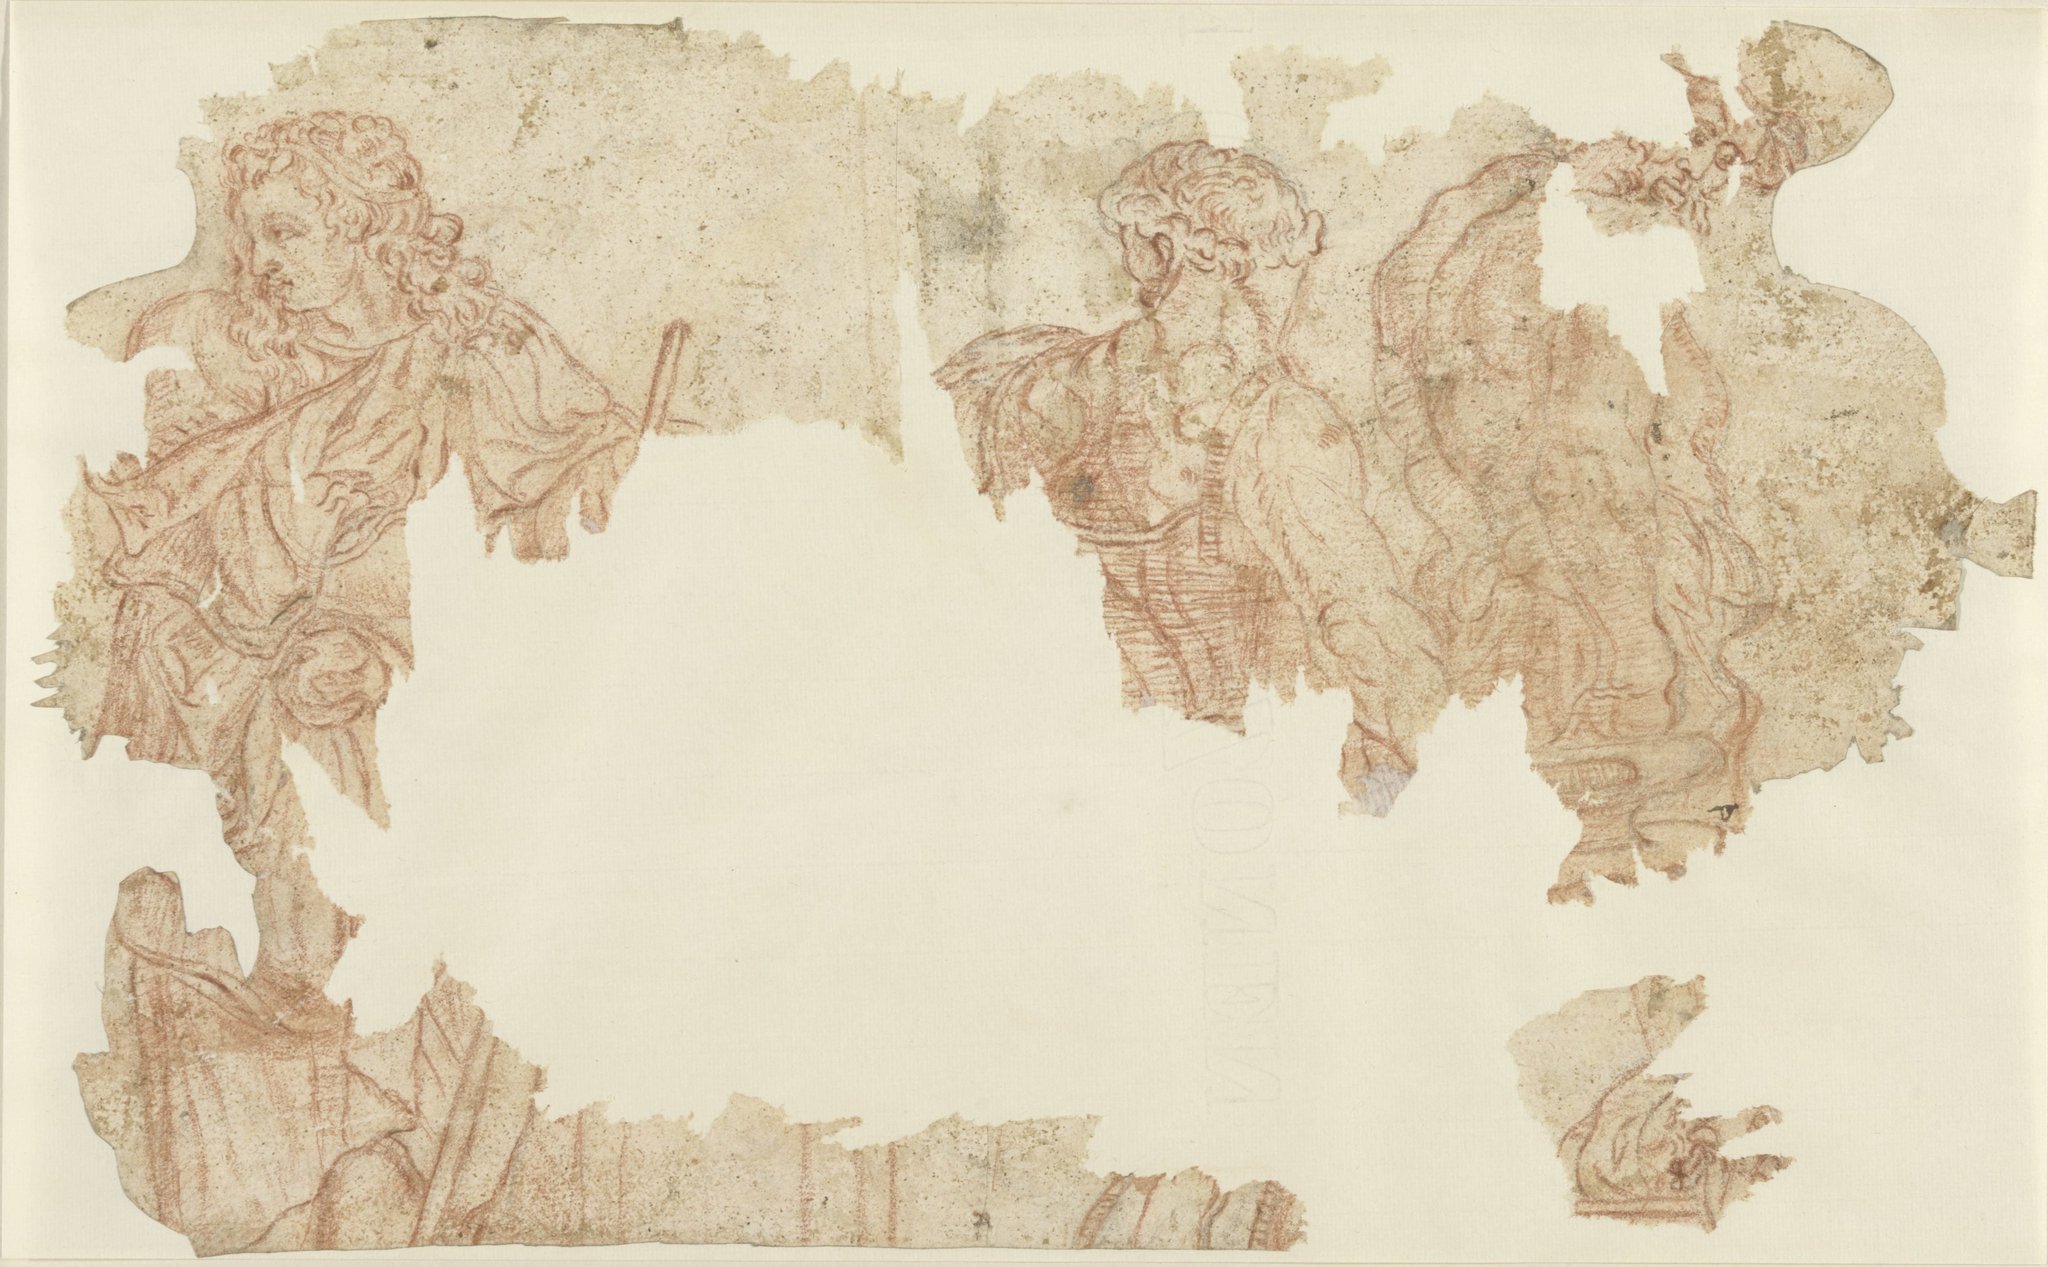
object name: drawing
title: Restanten van staande mannelijke figuren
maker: Anonymous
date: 1662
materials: chalk, paper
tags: standing figure